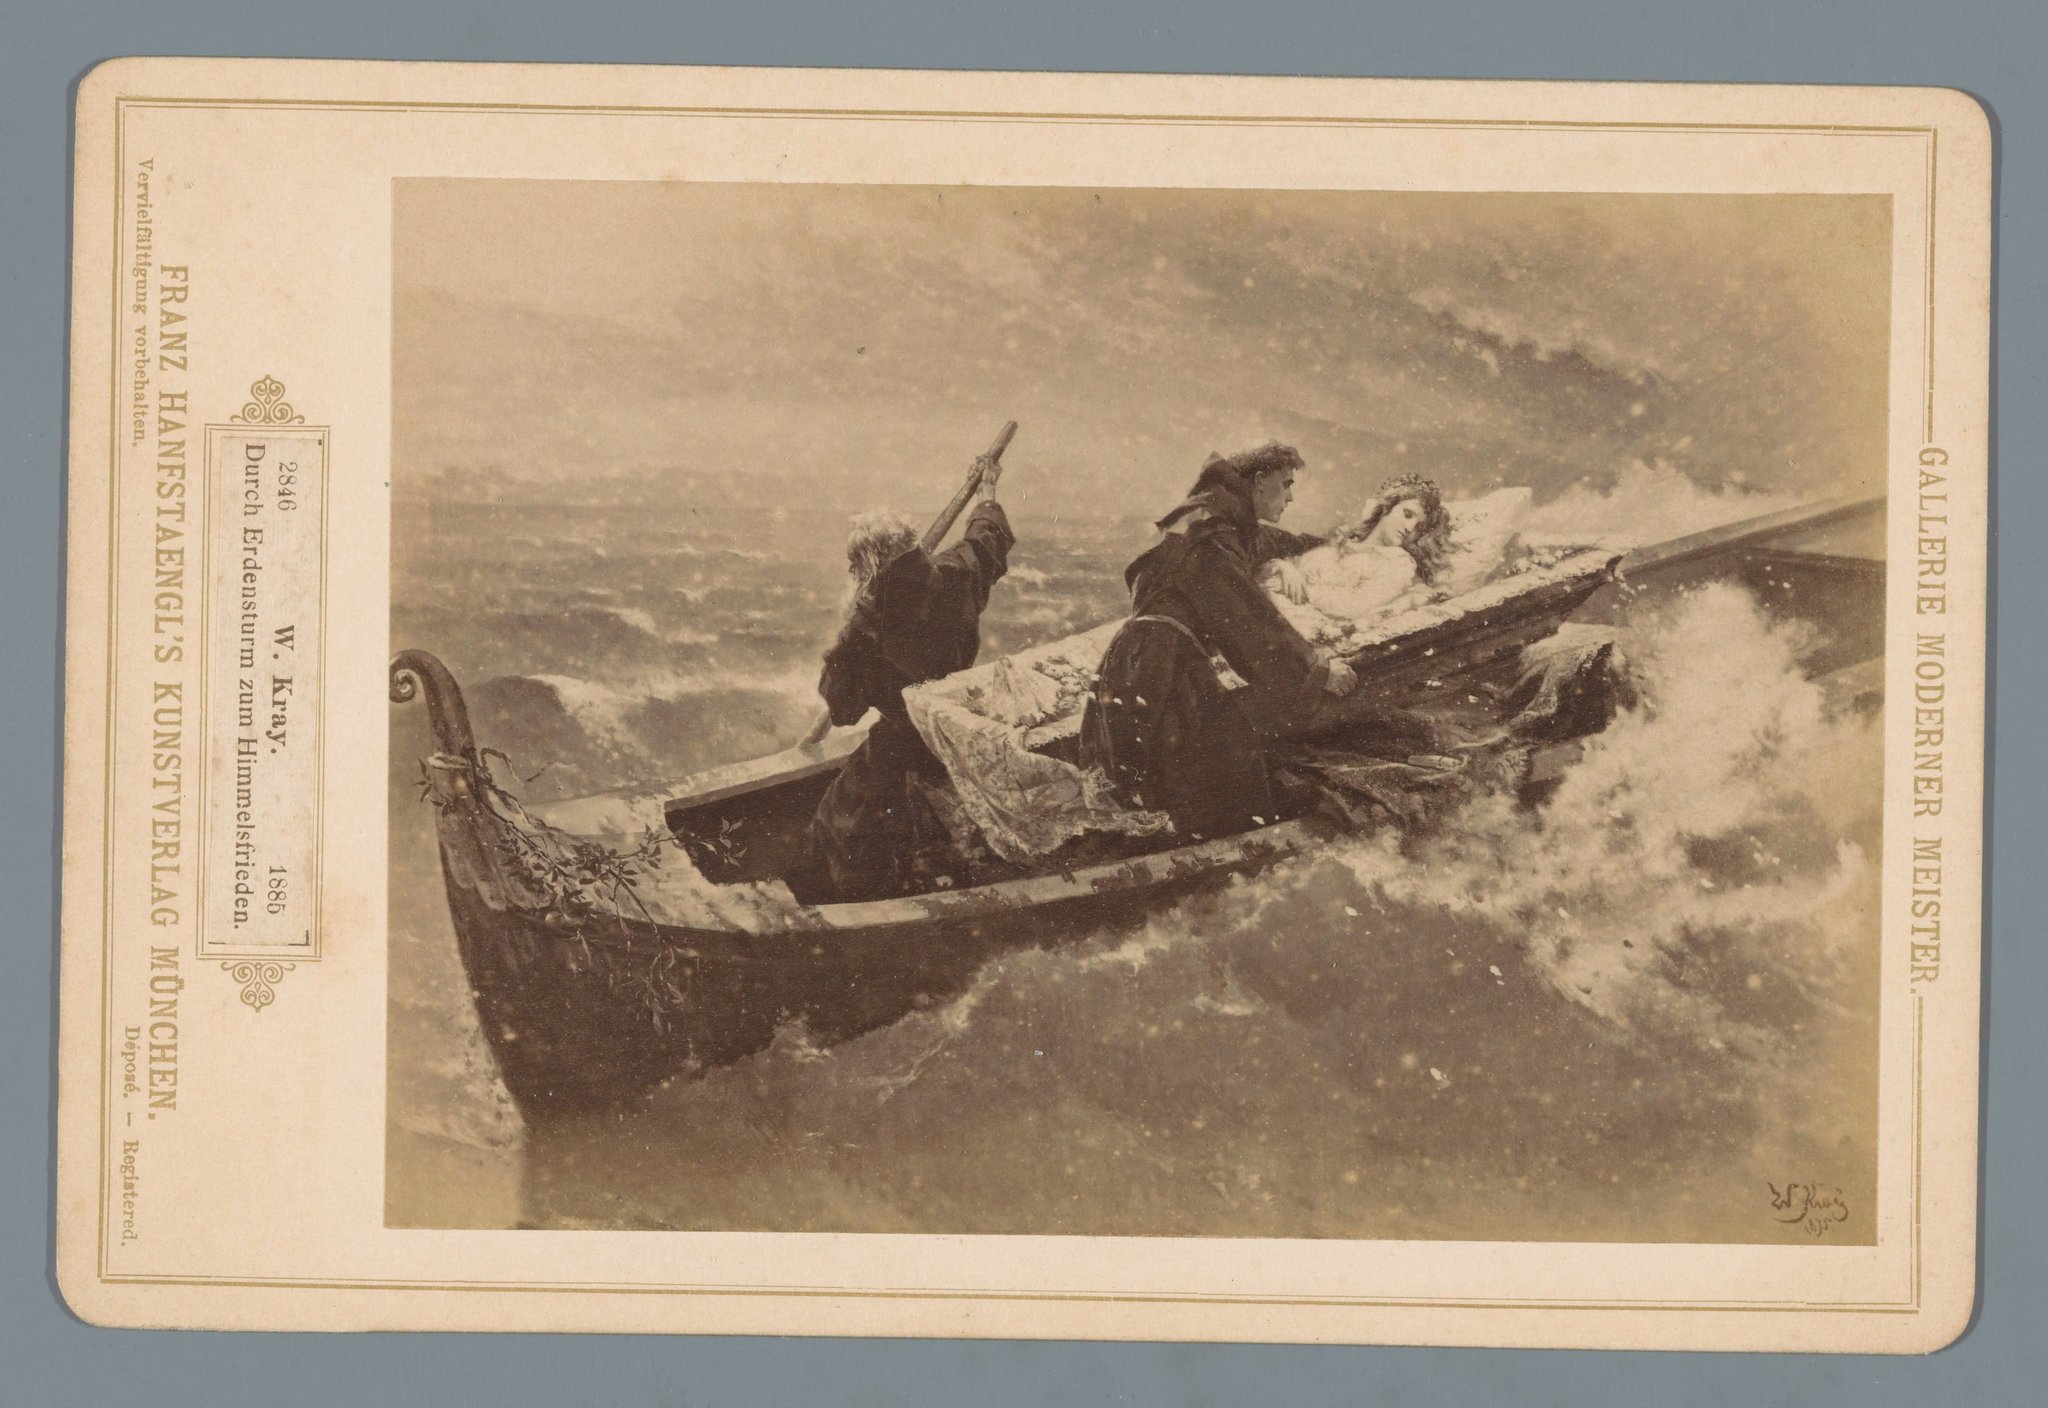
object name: cabinet photograph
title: Gallerie Moderner Meister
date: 1885-1910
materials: cardboard, photographic support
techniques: albumen print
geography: munich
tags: monk(s), friar(s), rowing-boat, canoe, etc.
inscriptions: number: ‘2846’